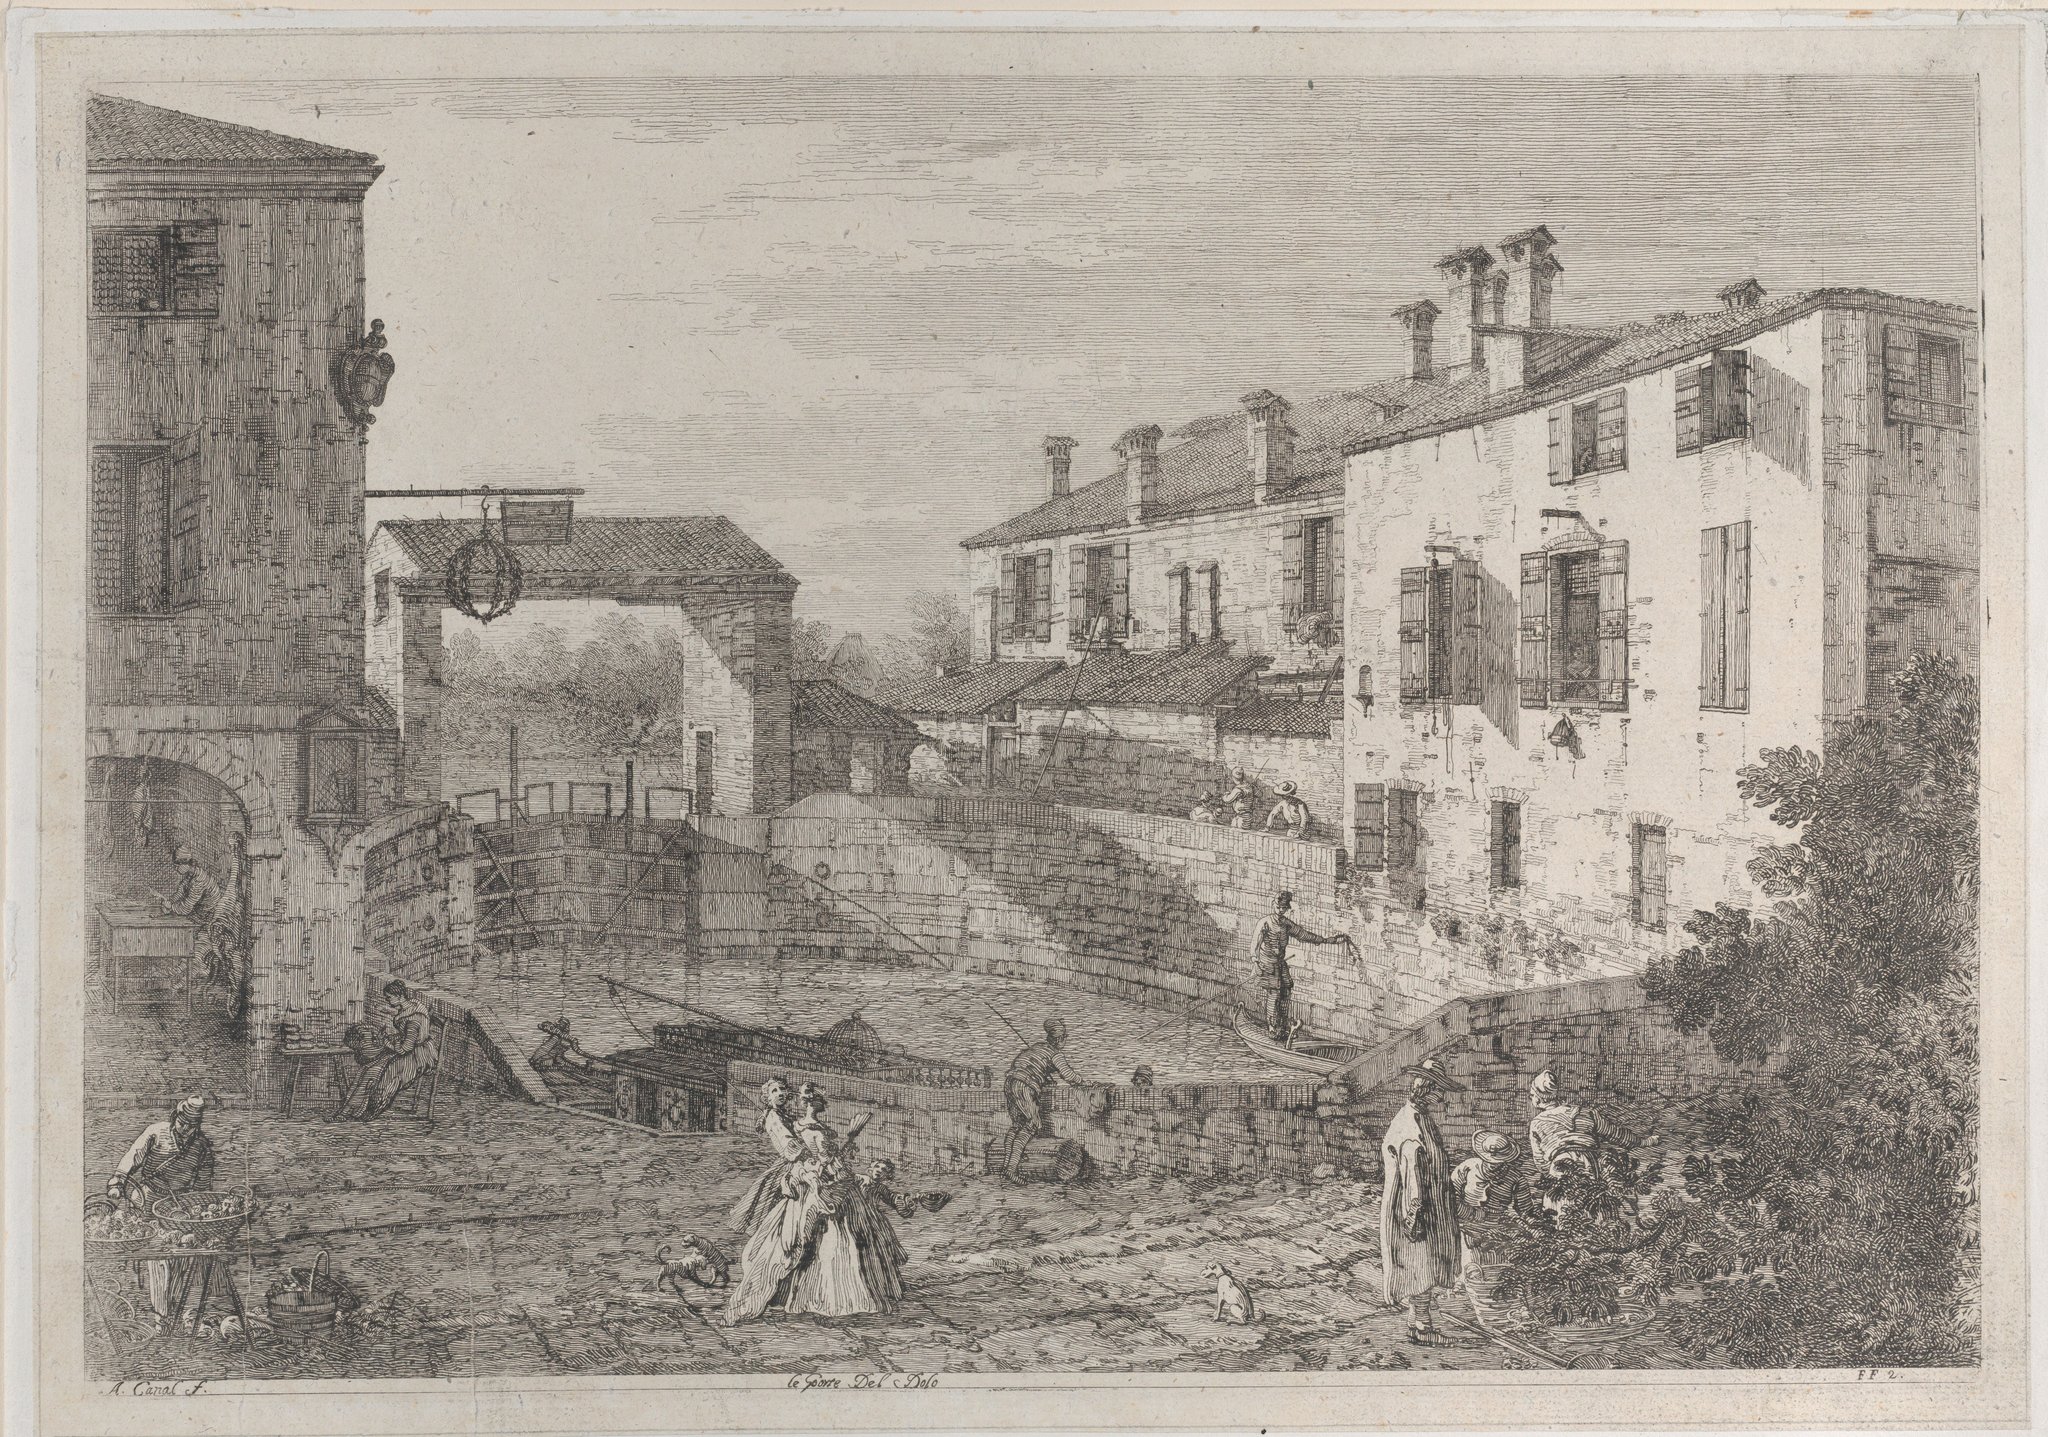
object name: print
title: Le porte del Dolo: the oval basin of the locks at Dolo, with a barge moored to the quay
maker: canaletto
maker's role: artist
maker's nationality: italian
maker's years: 1697-1768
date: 1735-1746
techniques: etching